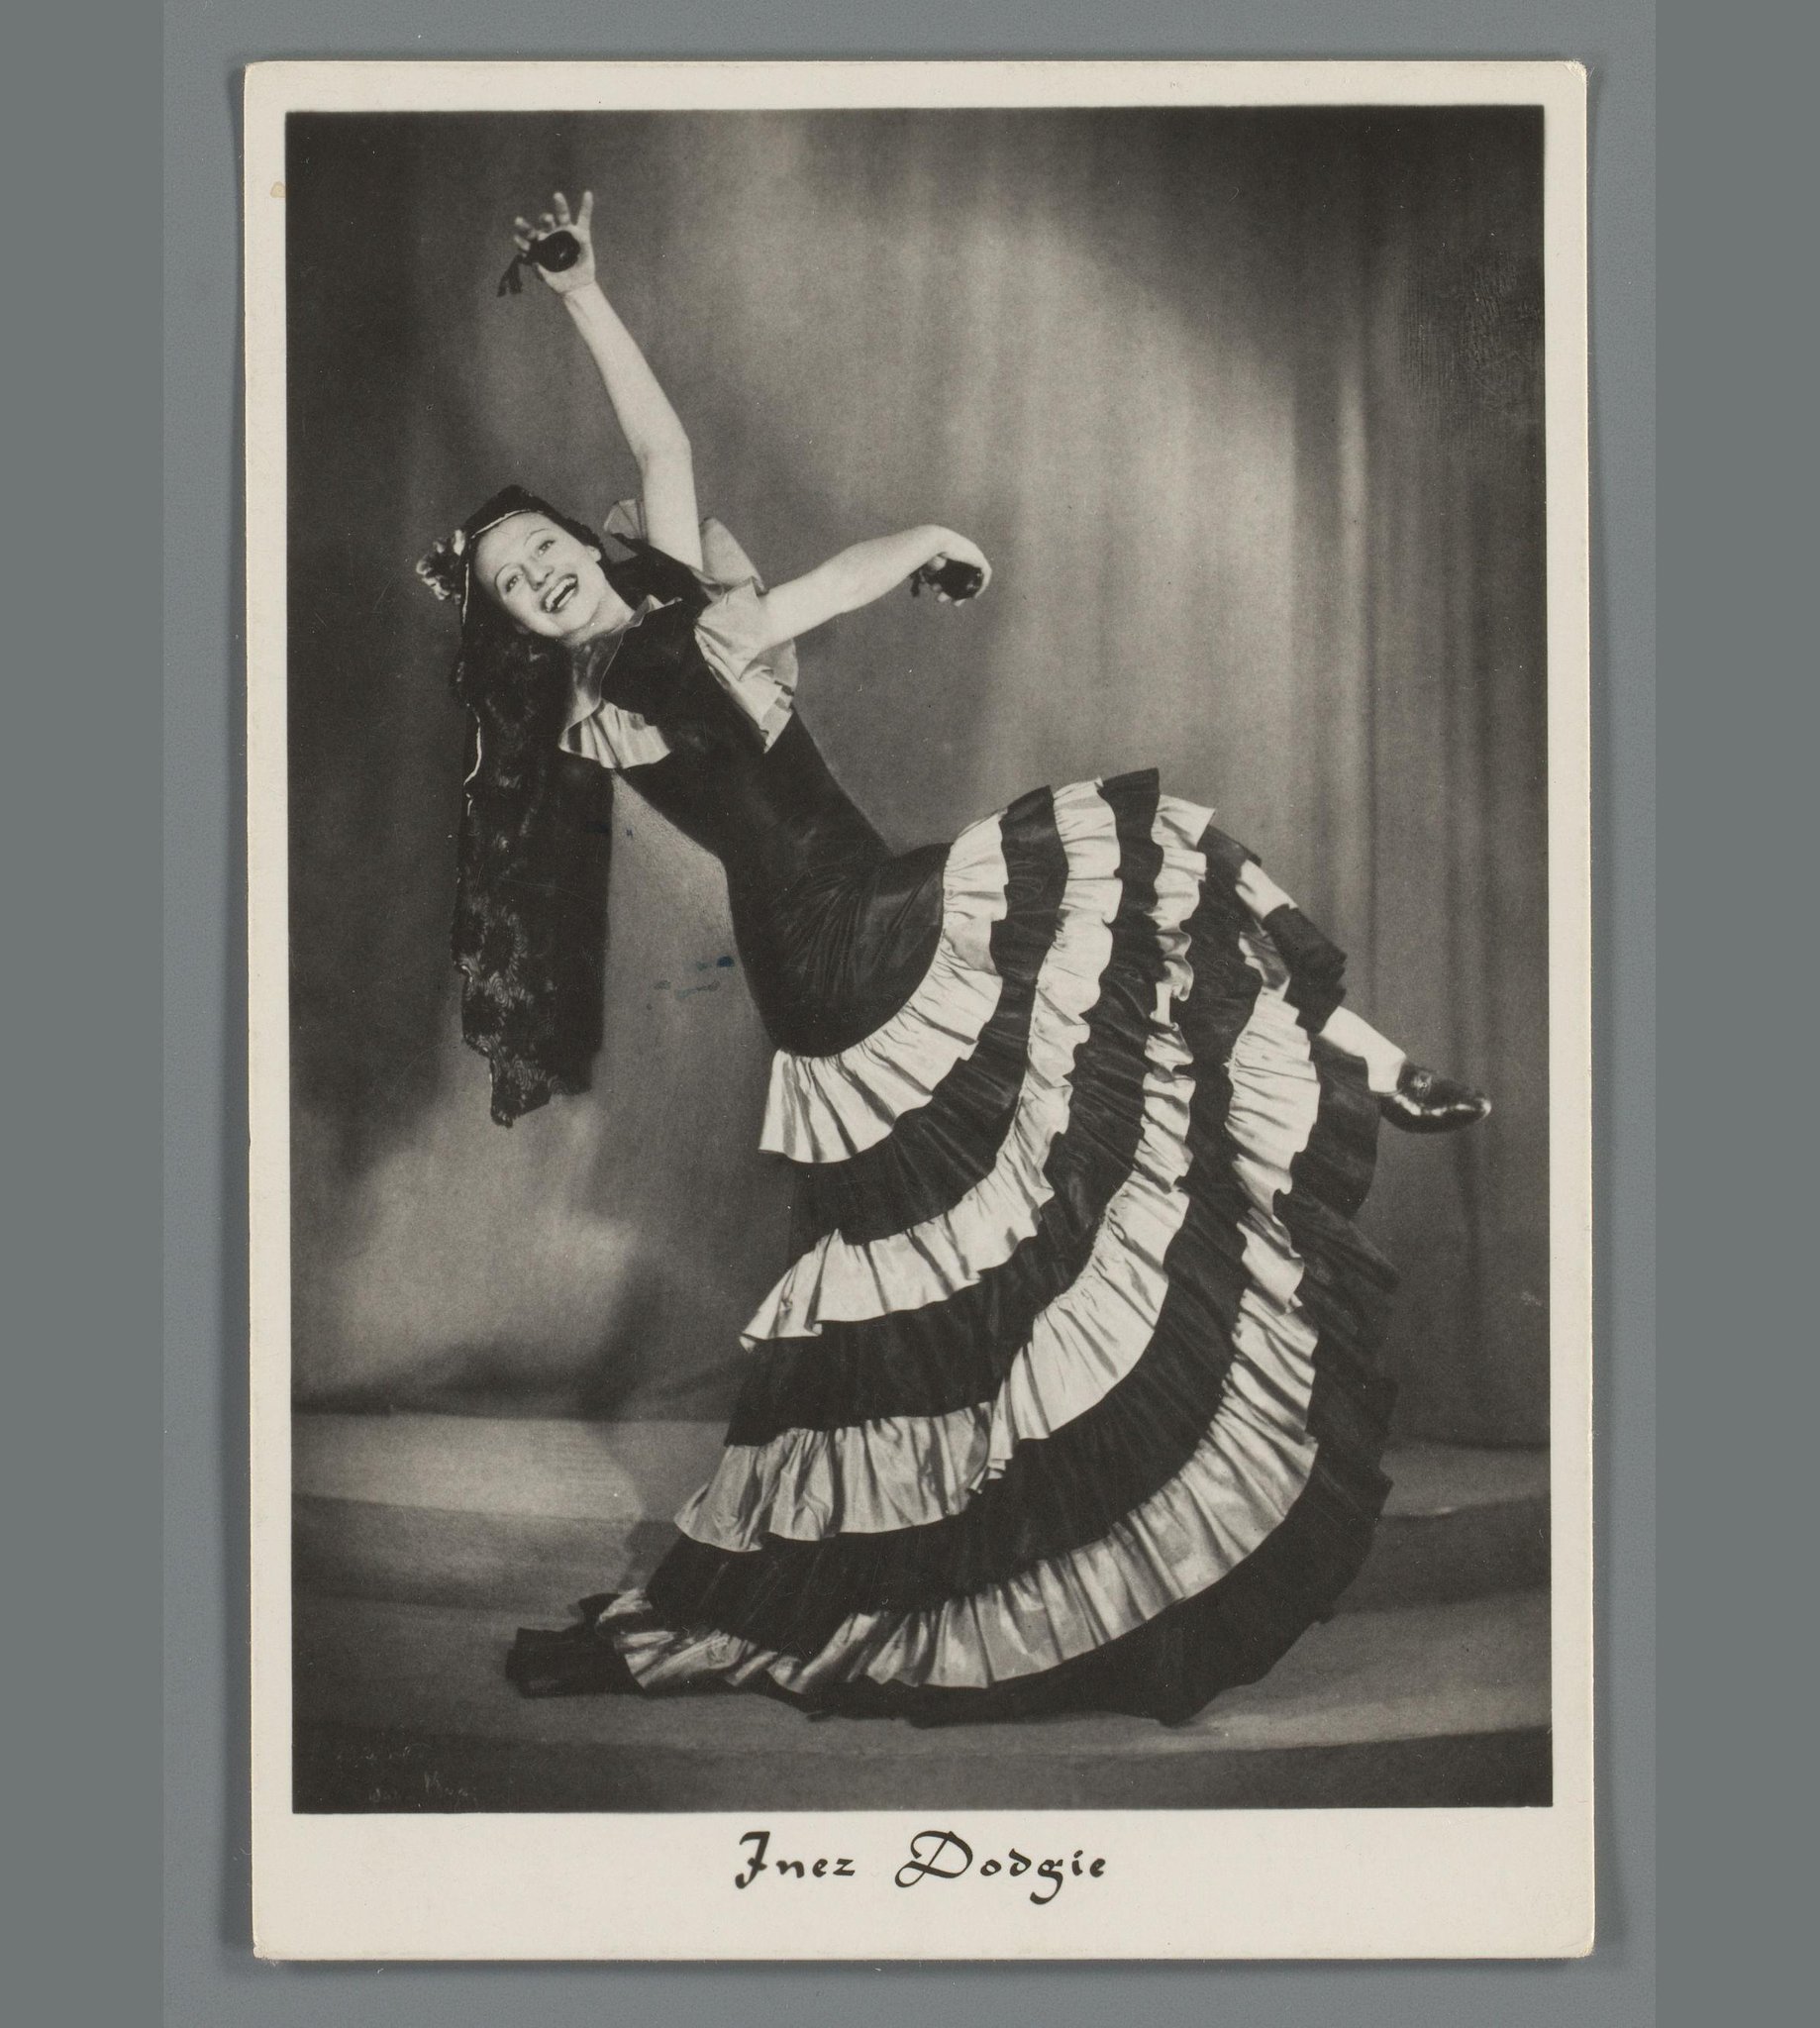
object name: photograph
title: Portret van Inez Dodgie, dansend in Spaanse klederdracht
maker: Anonymous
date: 1944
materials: paper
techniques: gelatin silver print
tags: woman dancing alone, historical persons - bb - woman, folk costume, regional costume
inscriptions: inscription: ‘Inez Dodgie/ Lange Houtstraat 1/ Den haag/ K 519’, inscription: ‘Aan mijn lieve vriendin/ Cato Merks, waar ik zoo/ gezellig mee in Piccadilly/ heb gewerk. Nog veel suc-/ ces. Inez Dodgie/ 3 Aug. 1944’, inscription: ‘Inez Dodgie’